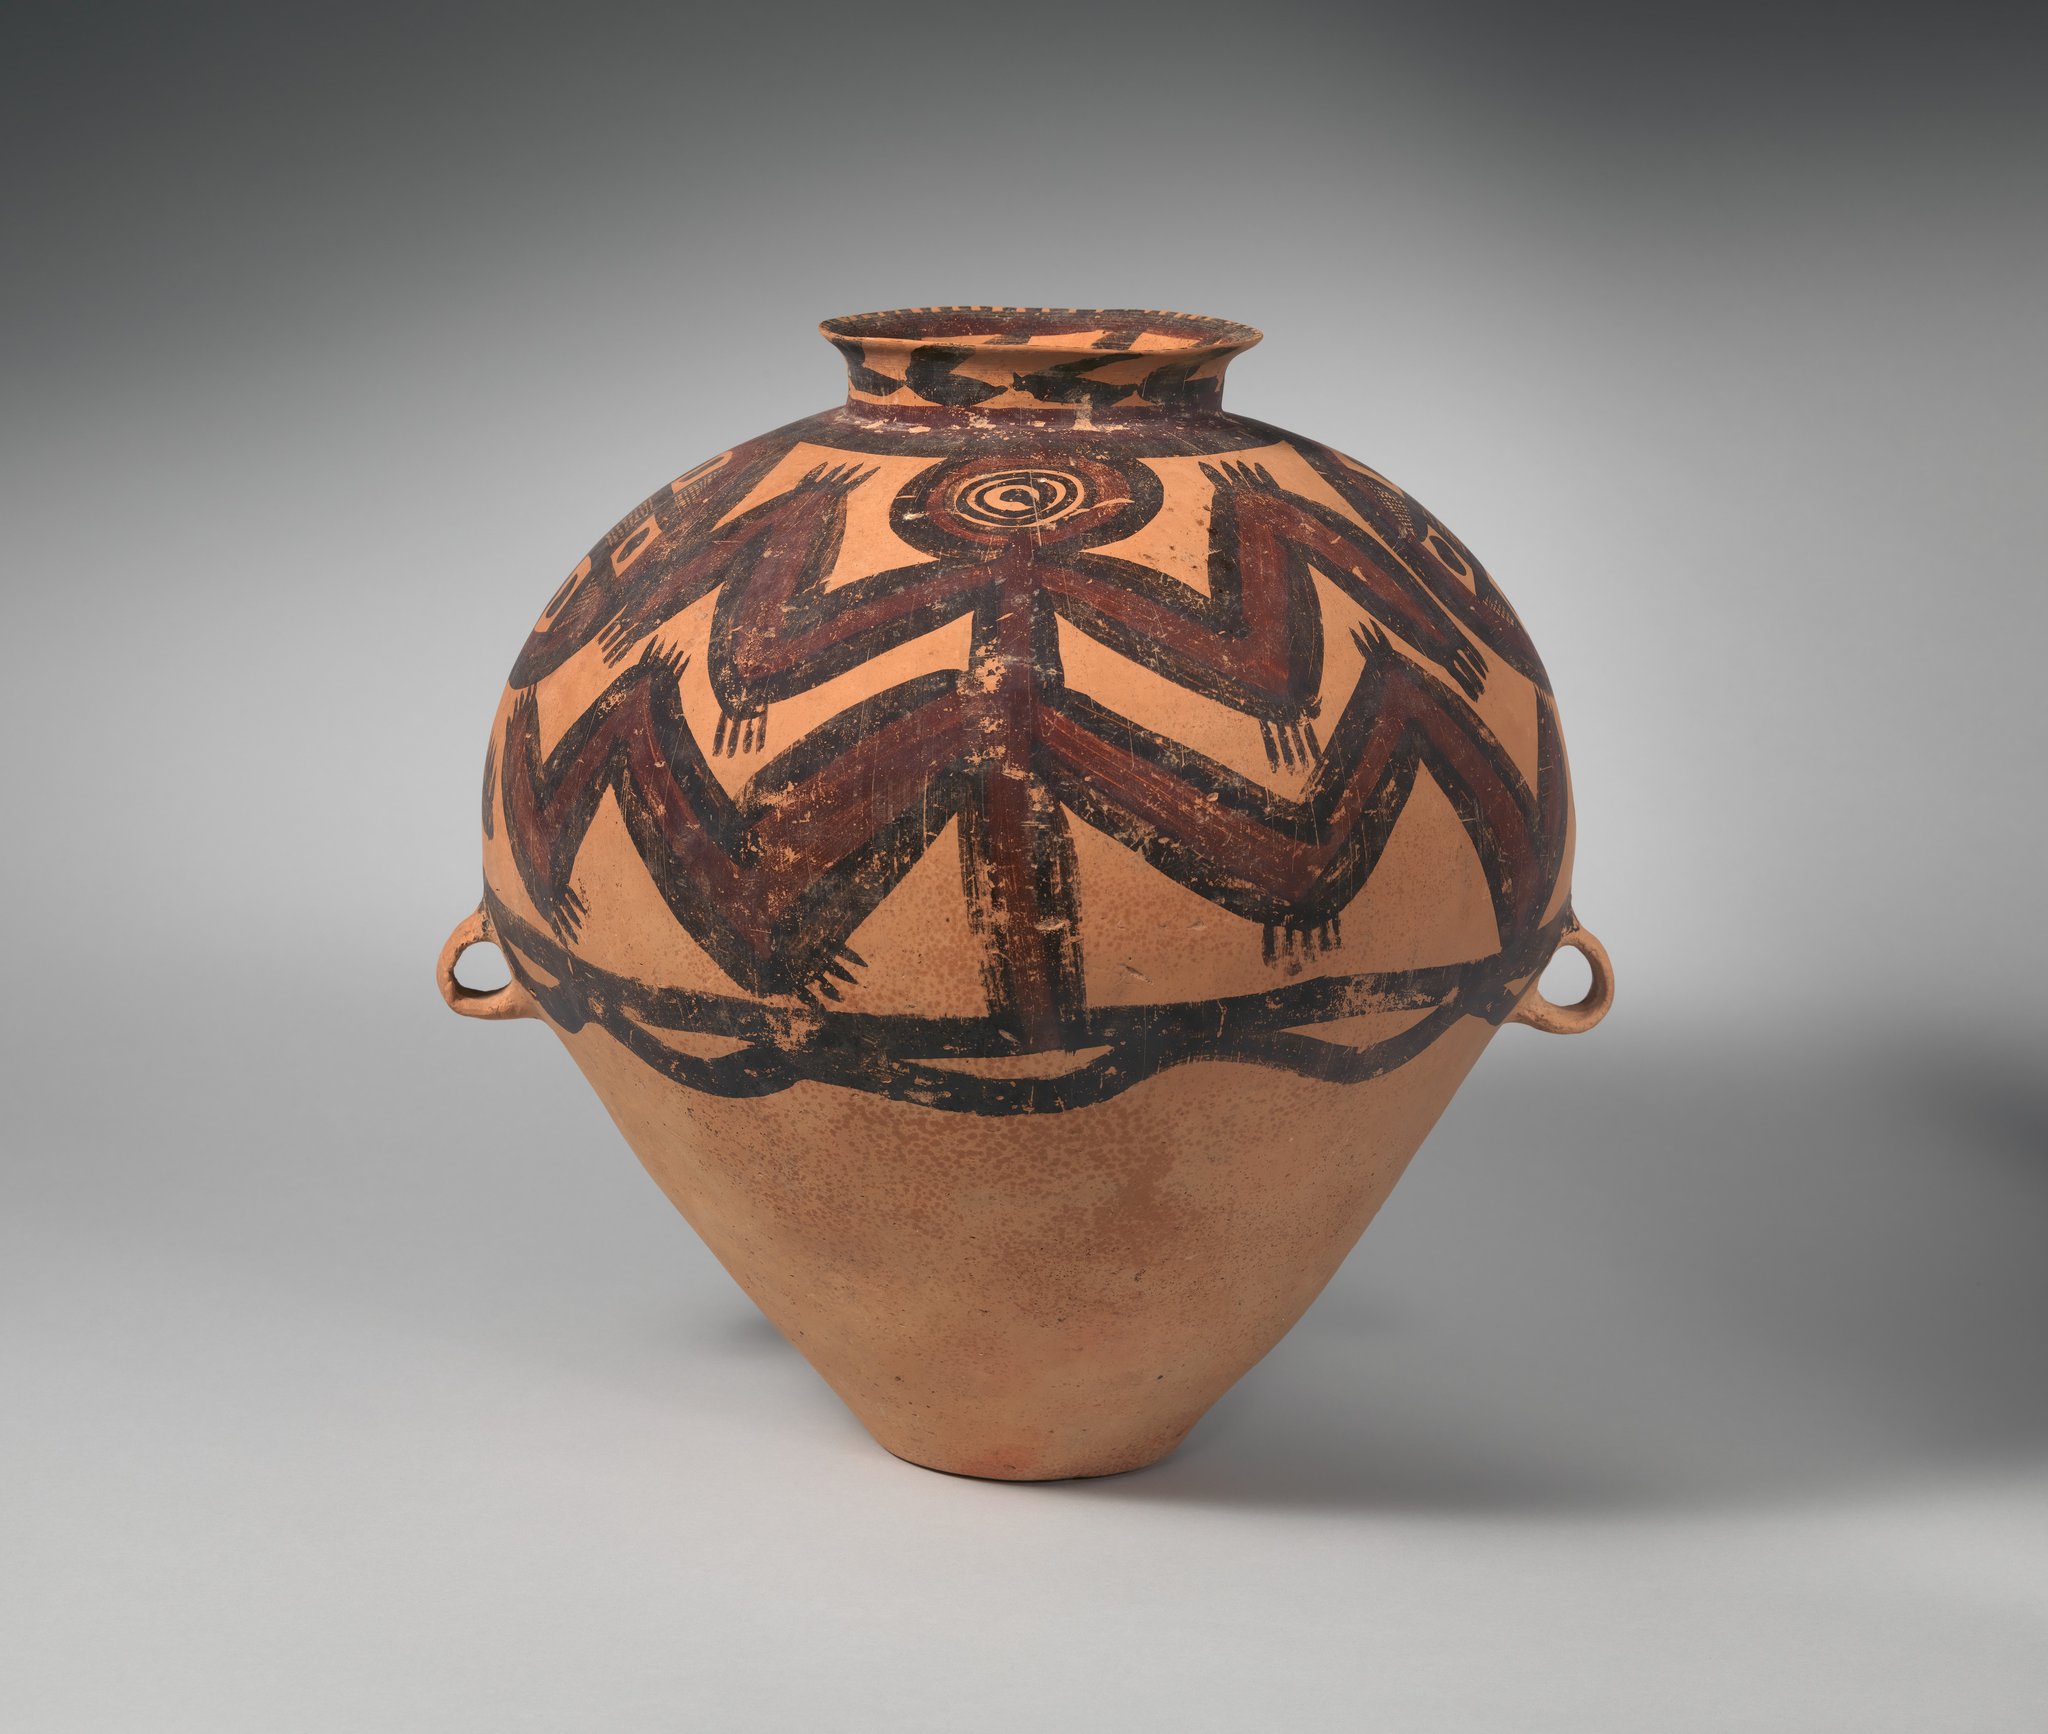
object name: jar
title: Jar with Painted Decoration of "Frog" Pattern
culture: chinese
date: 2300-2000 BCE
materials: earthenware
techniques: painting